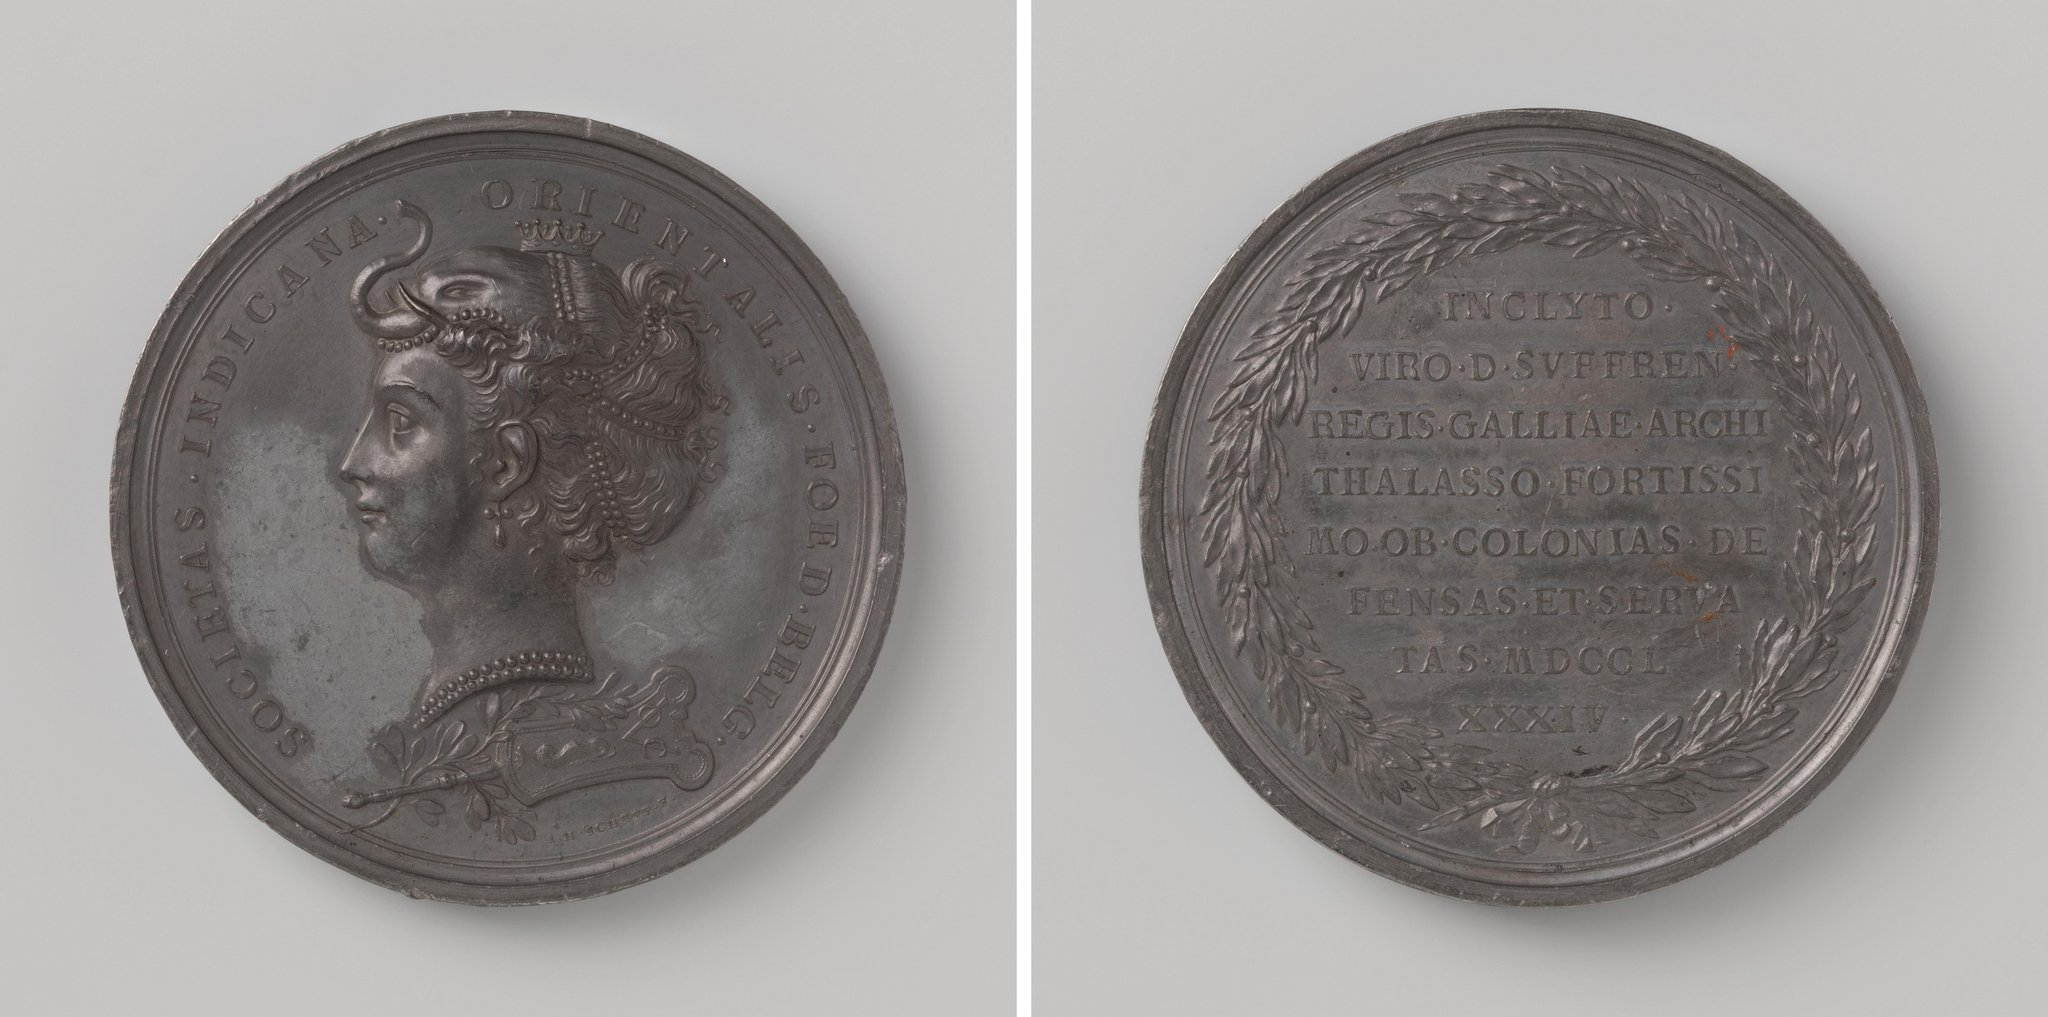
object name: honorary medal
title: Eerbetoon aan de Franse vice-admiraal De Suffren door de VOC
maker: johann heinrich schepp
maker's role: sculptor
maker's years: 1736-1811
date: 1784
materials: lead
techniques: striking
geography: the hague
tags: paris, dutch east indies, the, cape of good hope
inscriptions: circumscription: ‘SOCIETAS INDICANA ORIENTALIS FOED BELG’, inscription: ‘INCLYTO VIRO D SVFFREN REGIS GALLIAE ARCHI THALASSO FORTISSI MO OB COLONIAS DE FENSAS ET SERVA TAS MDCCL XXXIV’, signature: ‘I.H. SCHEPP F’